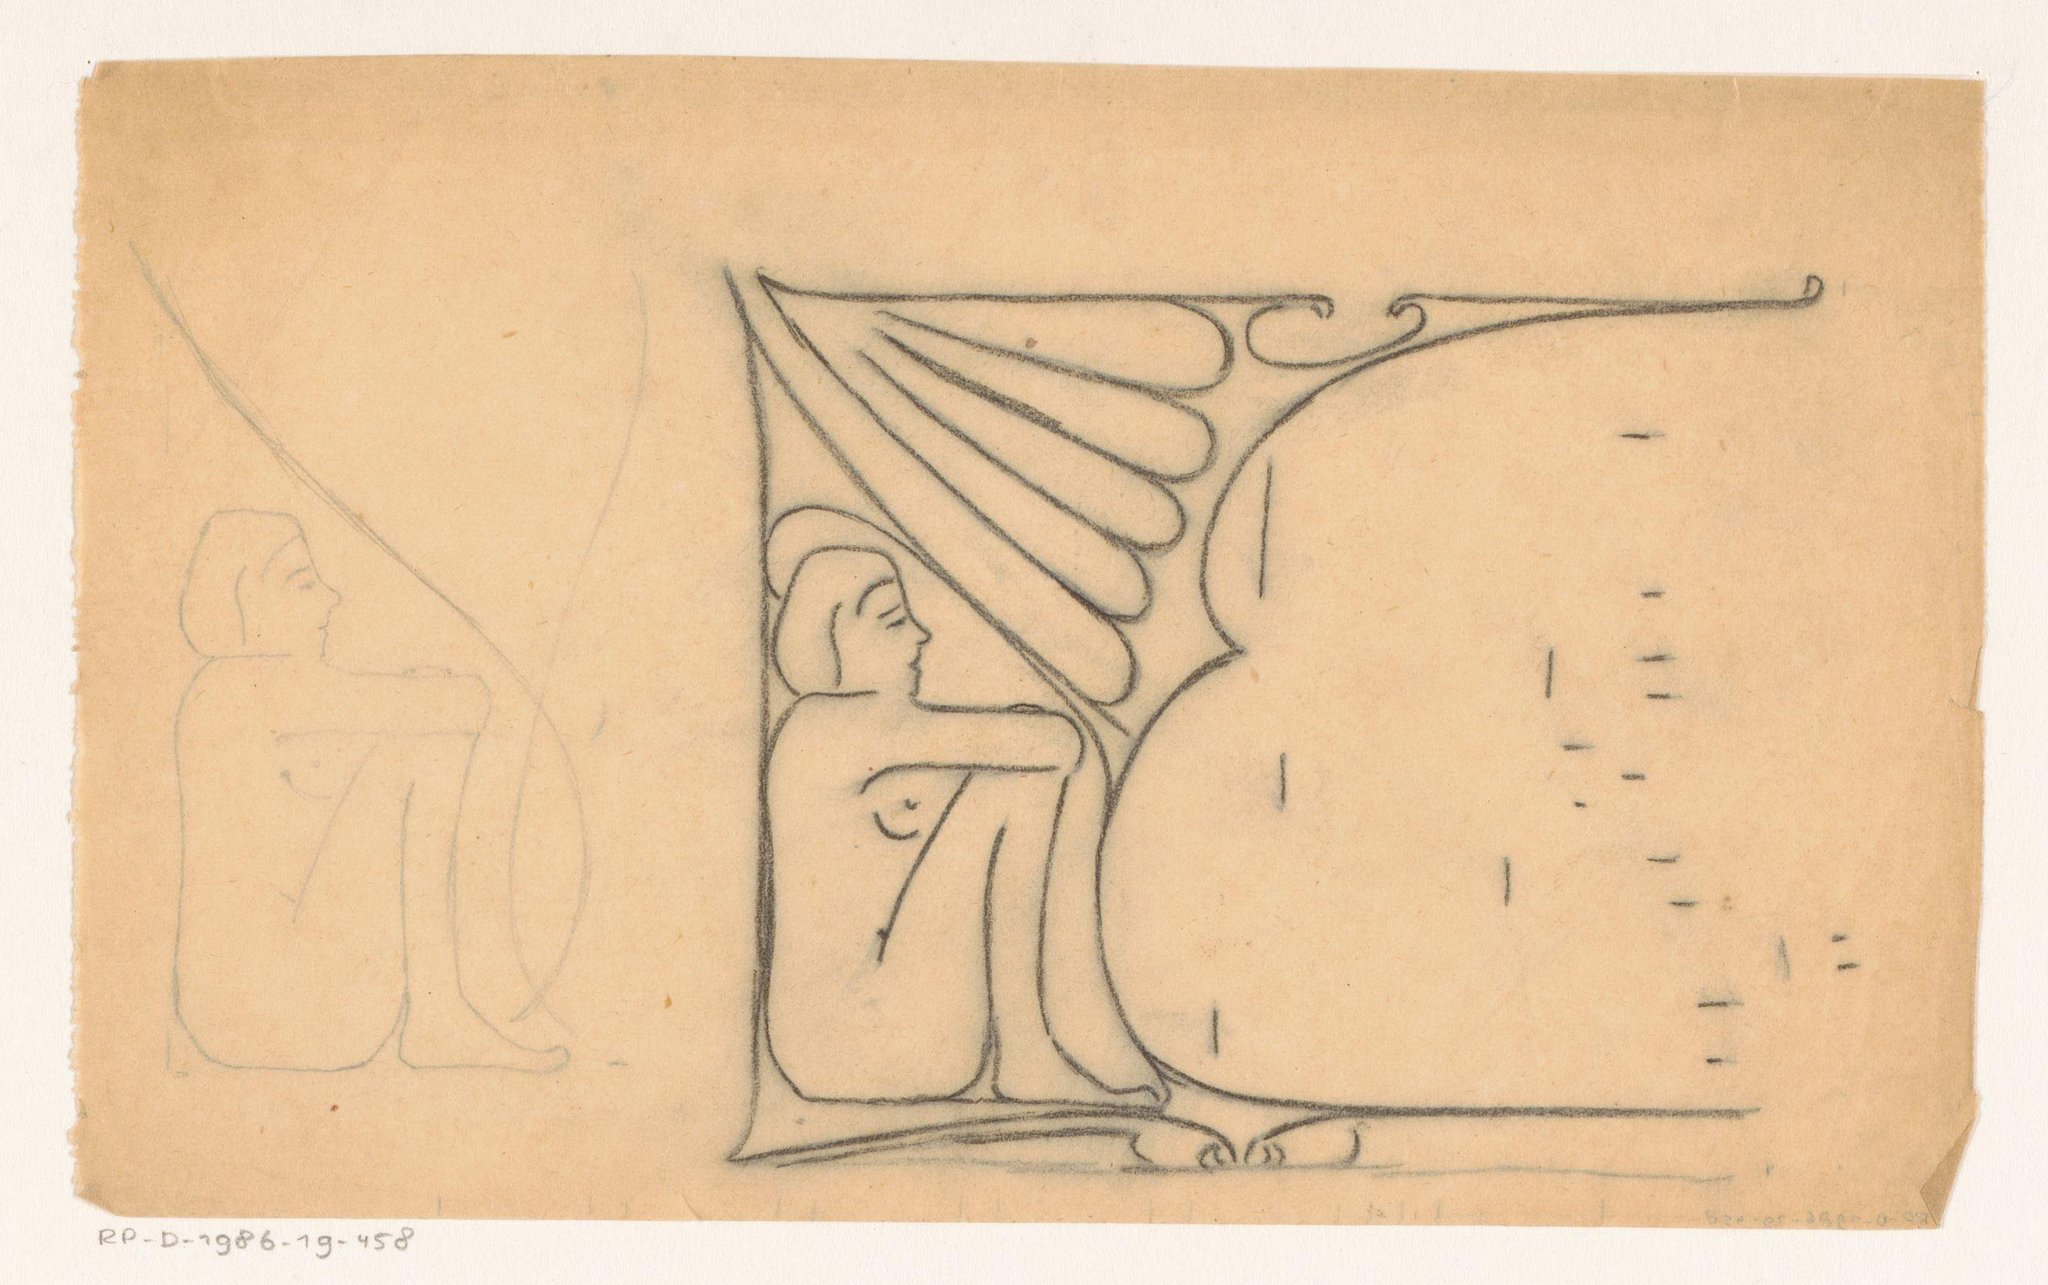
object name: drawing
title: Ontwerp voor een titelhoofd van: Arcadia, letterkundig maandblad voor dames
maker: reinier willem petrus de vries (1874-1953)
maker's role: draughtsman, print maker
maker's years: 1874-1953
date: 1900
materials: pencil, paper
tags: sitting figure - aa - female human figure, the (nude) human figure; 'corpo humano' (ripa) - aa - female human figure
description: Zittende naakte vrouw met opgetrokken knieën.